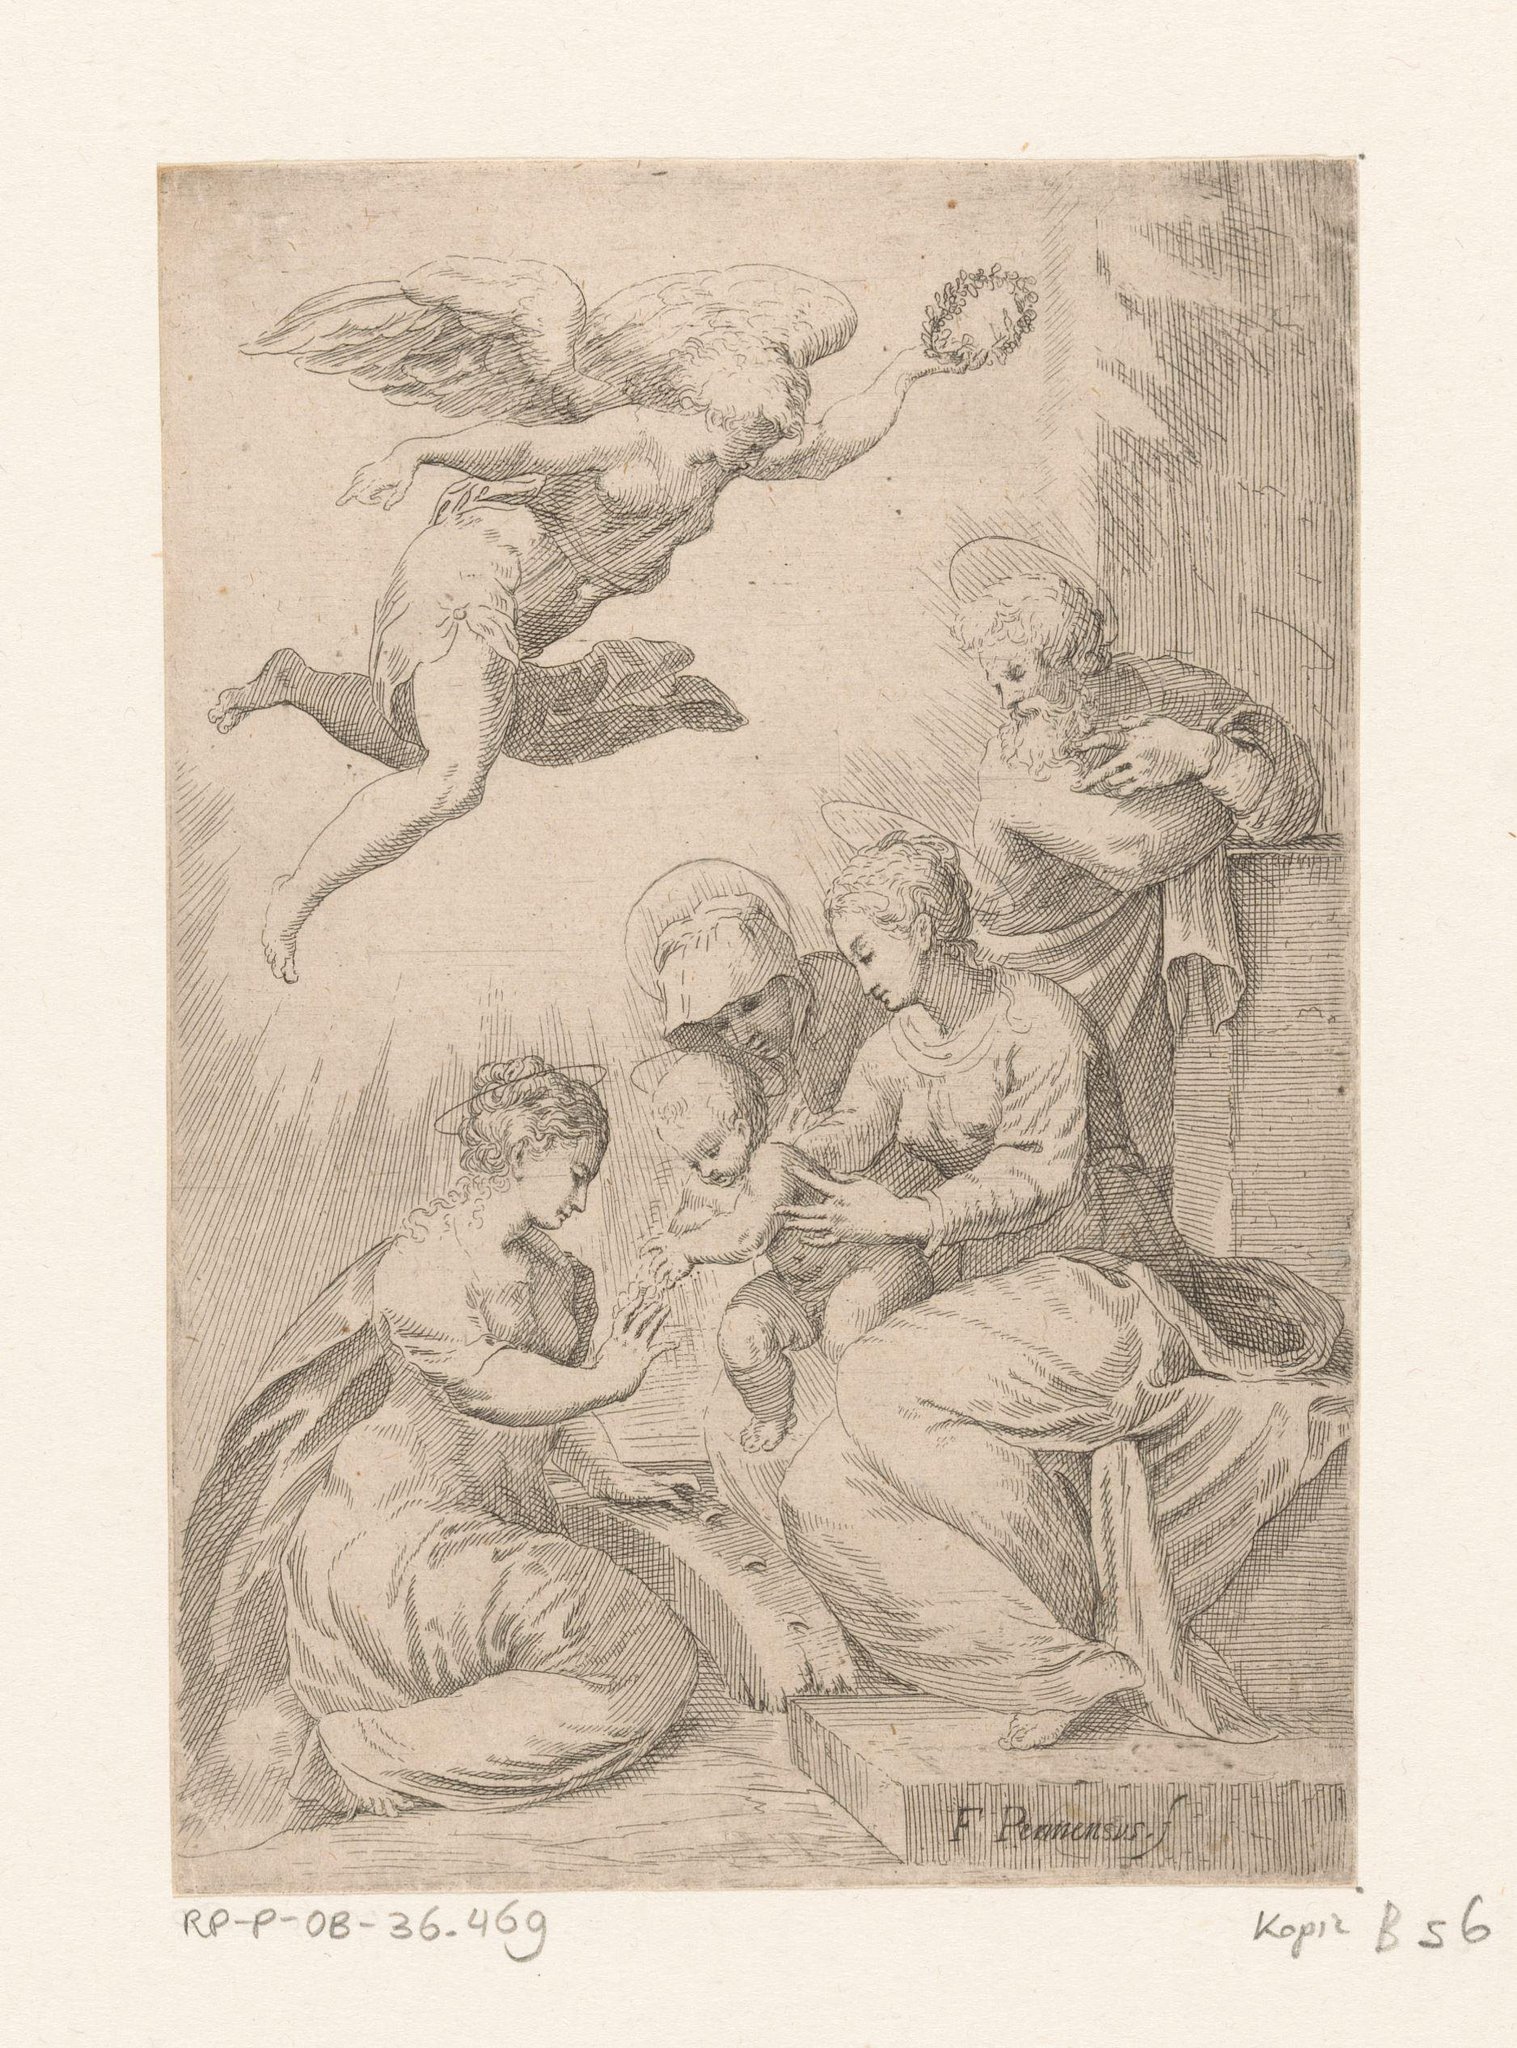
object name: print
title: Mystieke huwelijk van de heilige Catharina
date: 1547-1586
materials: paper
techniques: etching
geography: italy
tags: the mystic marriage of st. catherine of alexandria with the infant christ: the christ-child puts a ring on her finger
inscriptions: collector's mark: Lugt 240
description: Maria zit met het Christuskind op schoot. Anna knielt naast hen. Christus schuift een ring aan de vinger van de heilige Catharina die voor hem knielt. Op de achtergrond staat Jozef tegen een muur. Boven zweeft een engel met een lauwerkrans.